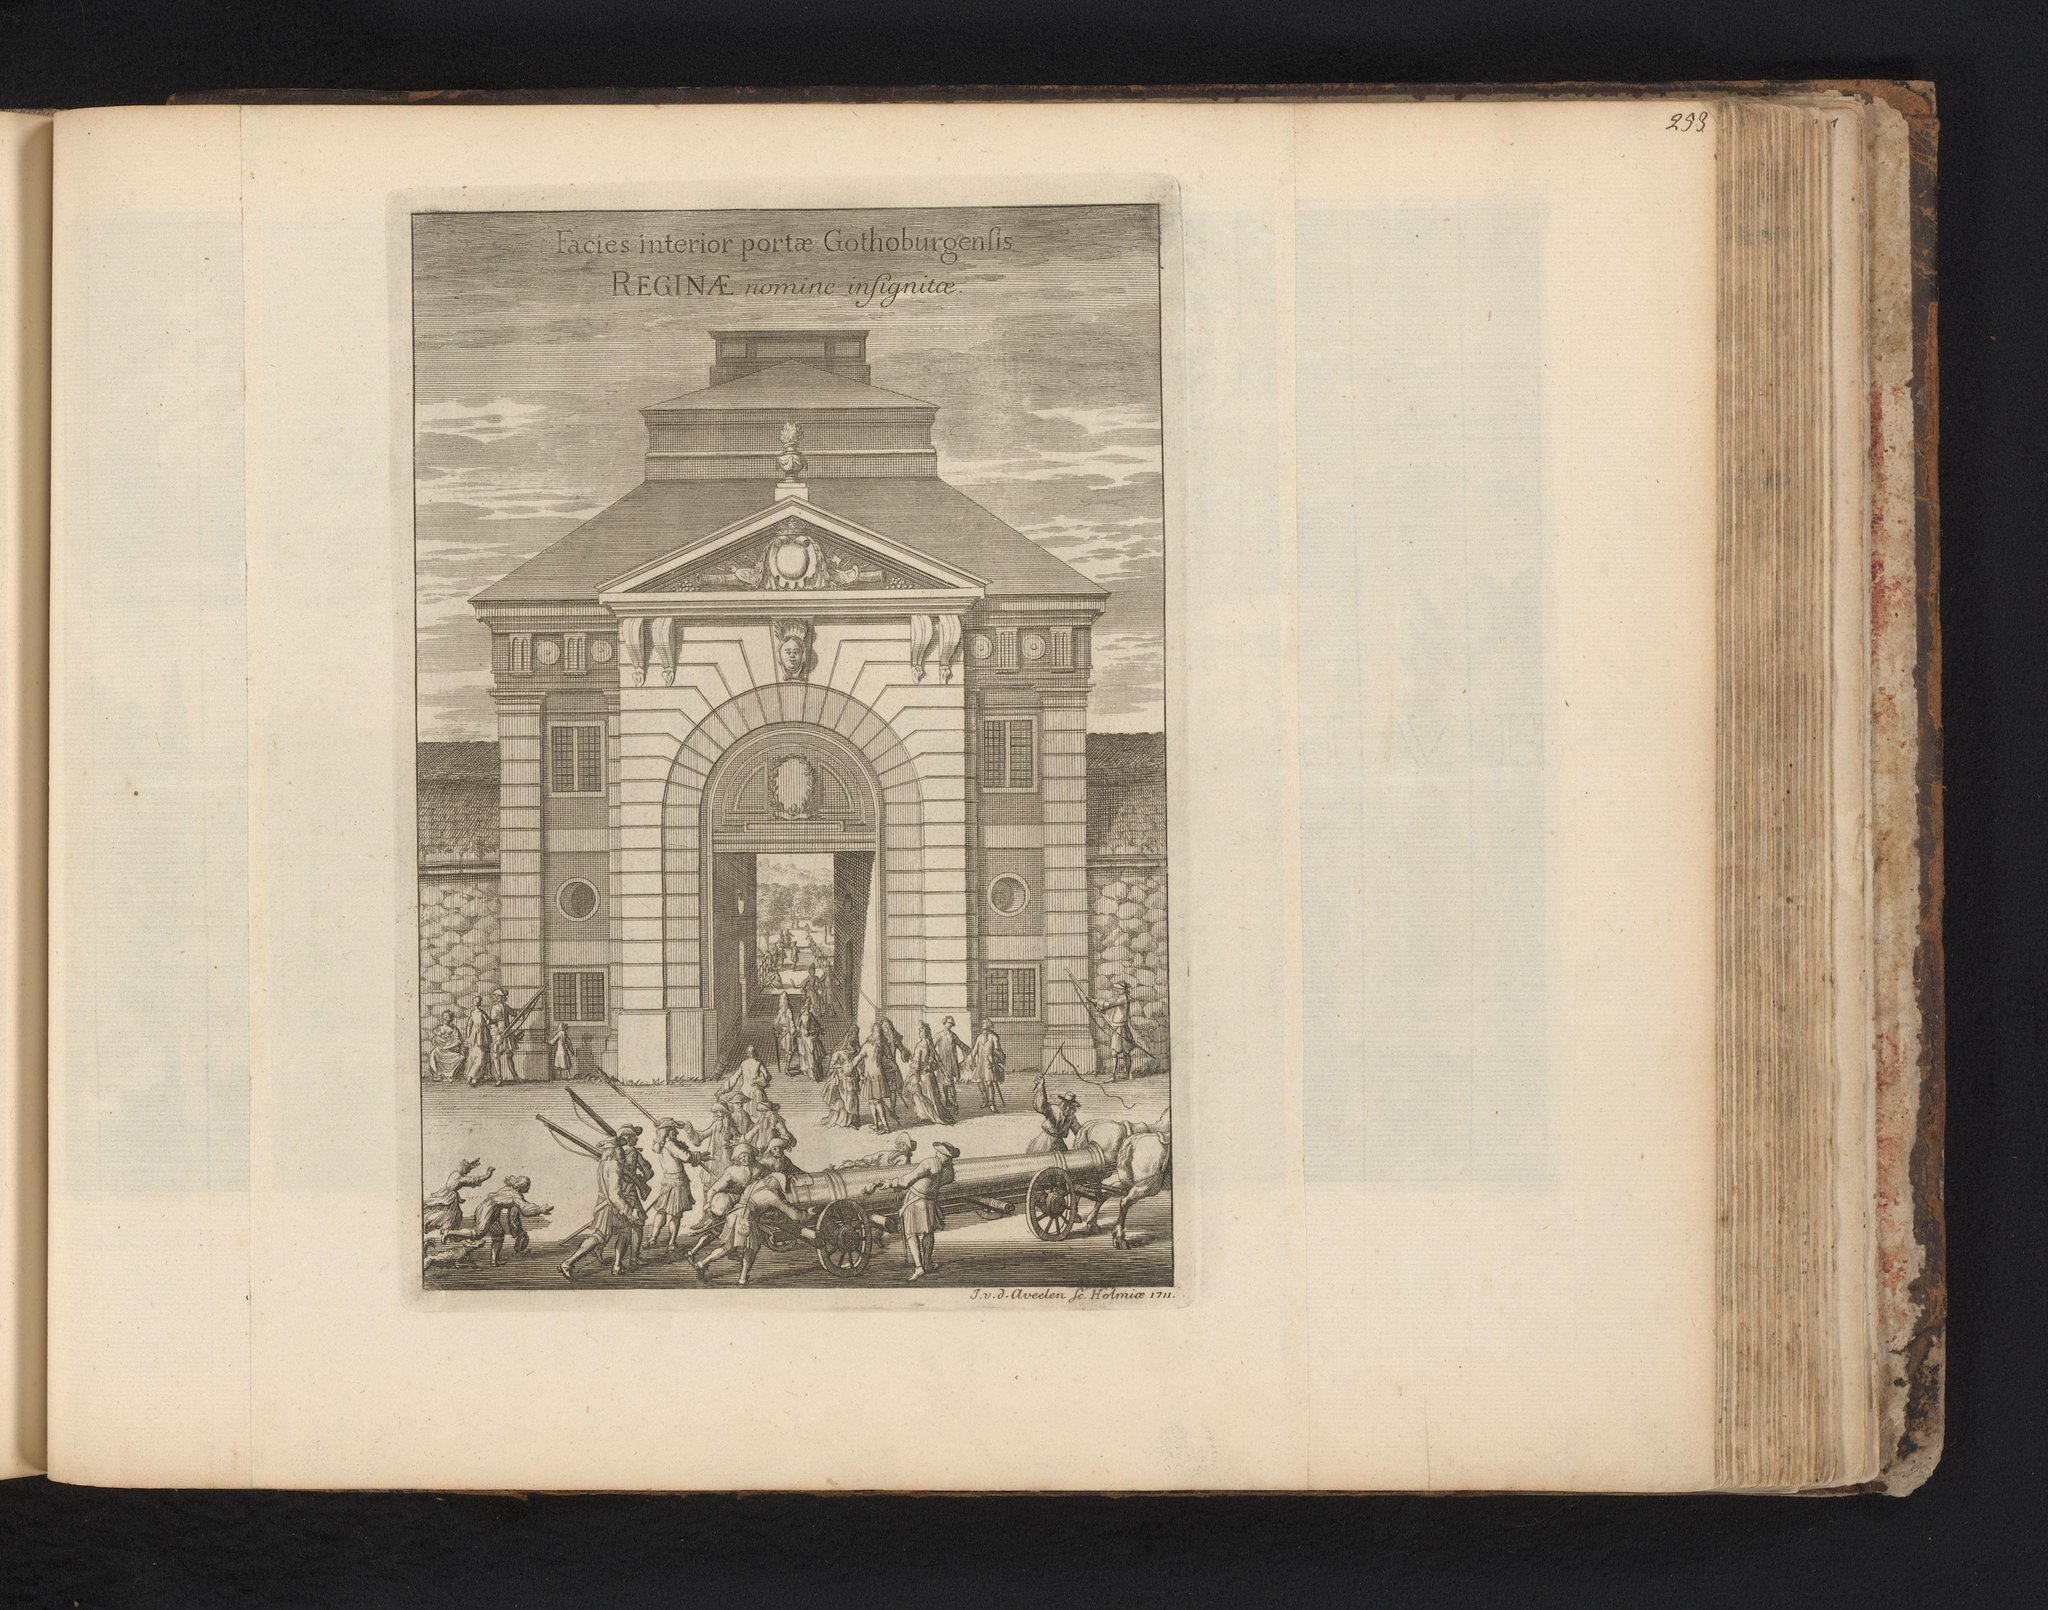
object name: print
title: Facies interior portae Gothoburgensis Reginae nomine insignitae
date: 1711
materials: paper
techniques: etching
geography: stockholm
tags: city-gate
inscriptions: date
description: Kungliga Biblioteket, 'Suecia': http://www.kb.se/samlingarna/Kartor-bilder/Suecia-antiqua/ (geraadpleegd november 2016).